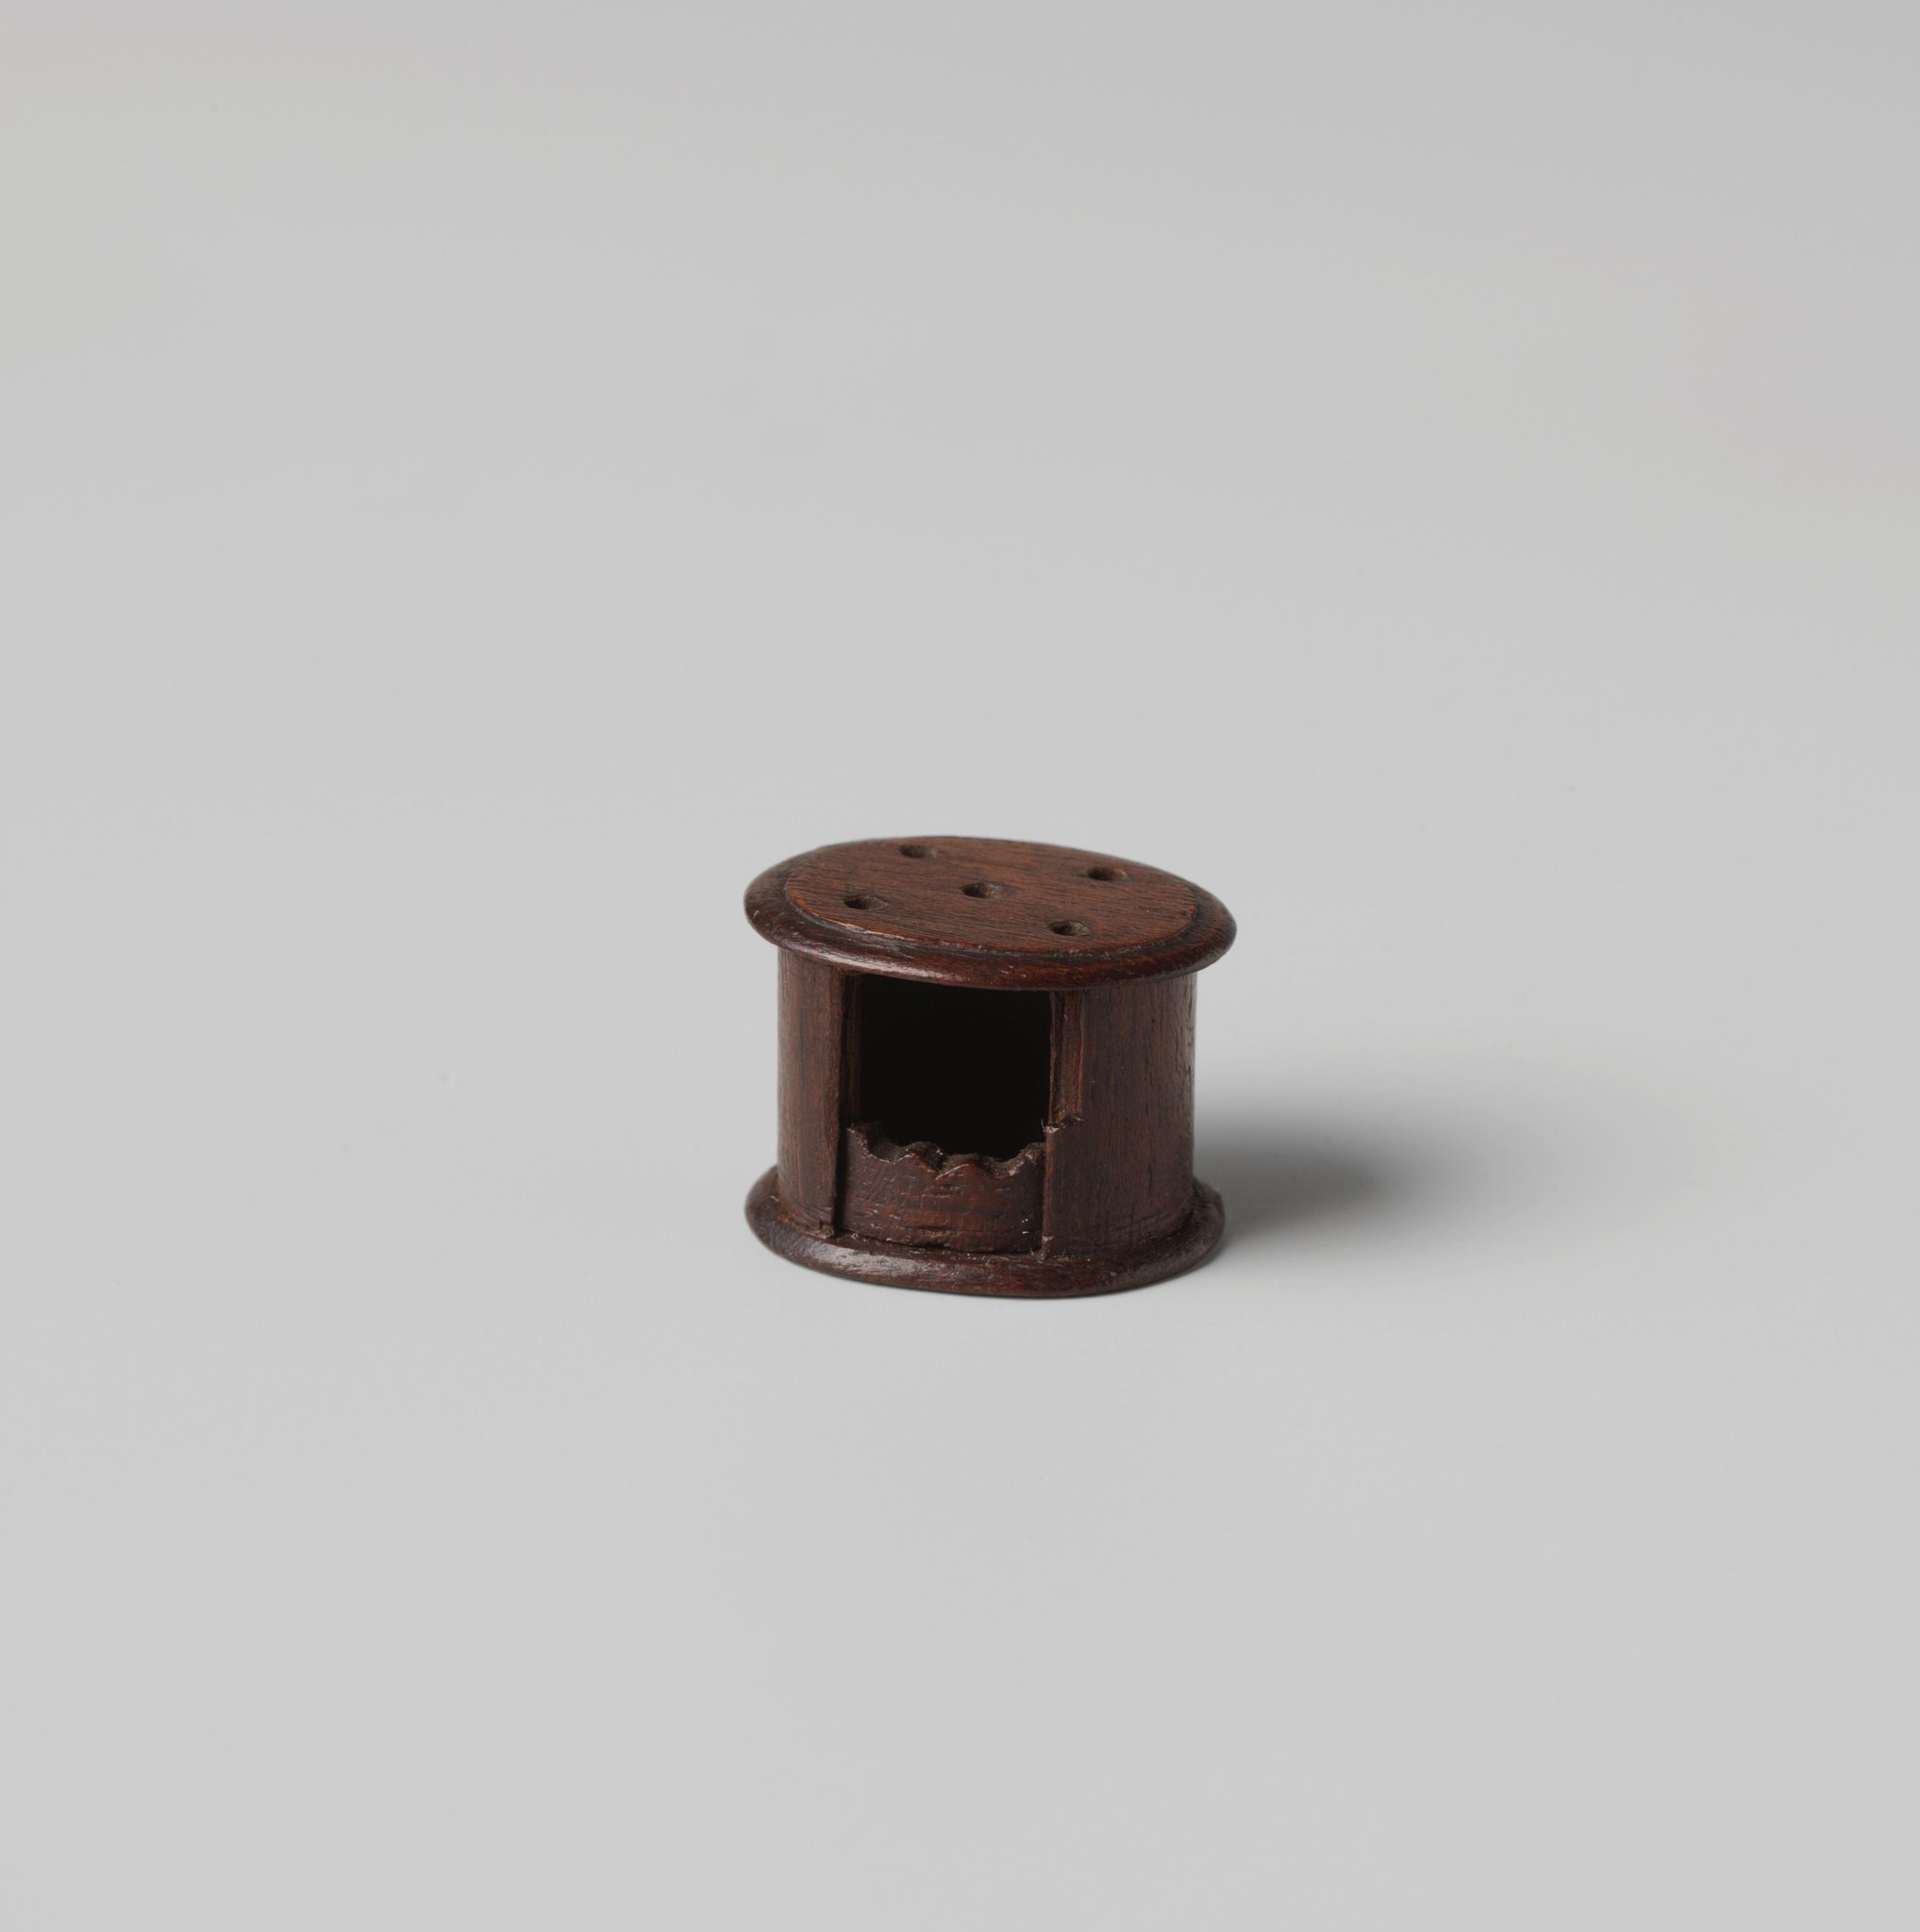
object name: miniature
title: Stoof, ovaal, met vijf gaten in de bovenzijde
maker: Anonymous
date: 1740-1760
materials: wood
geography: amsterdam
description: Stoof van mahoniehout, ovaal, met in de bovenzijde vijf gaten.